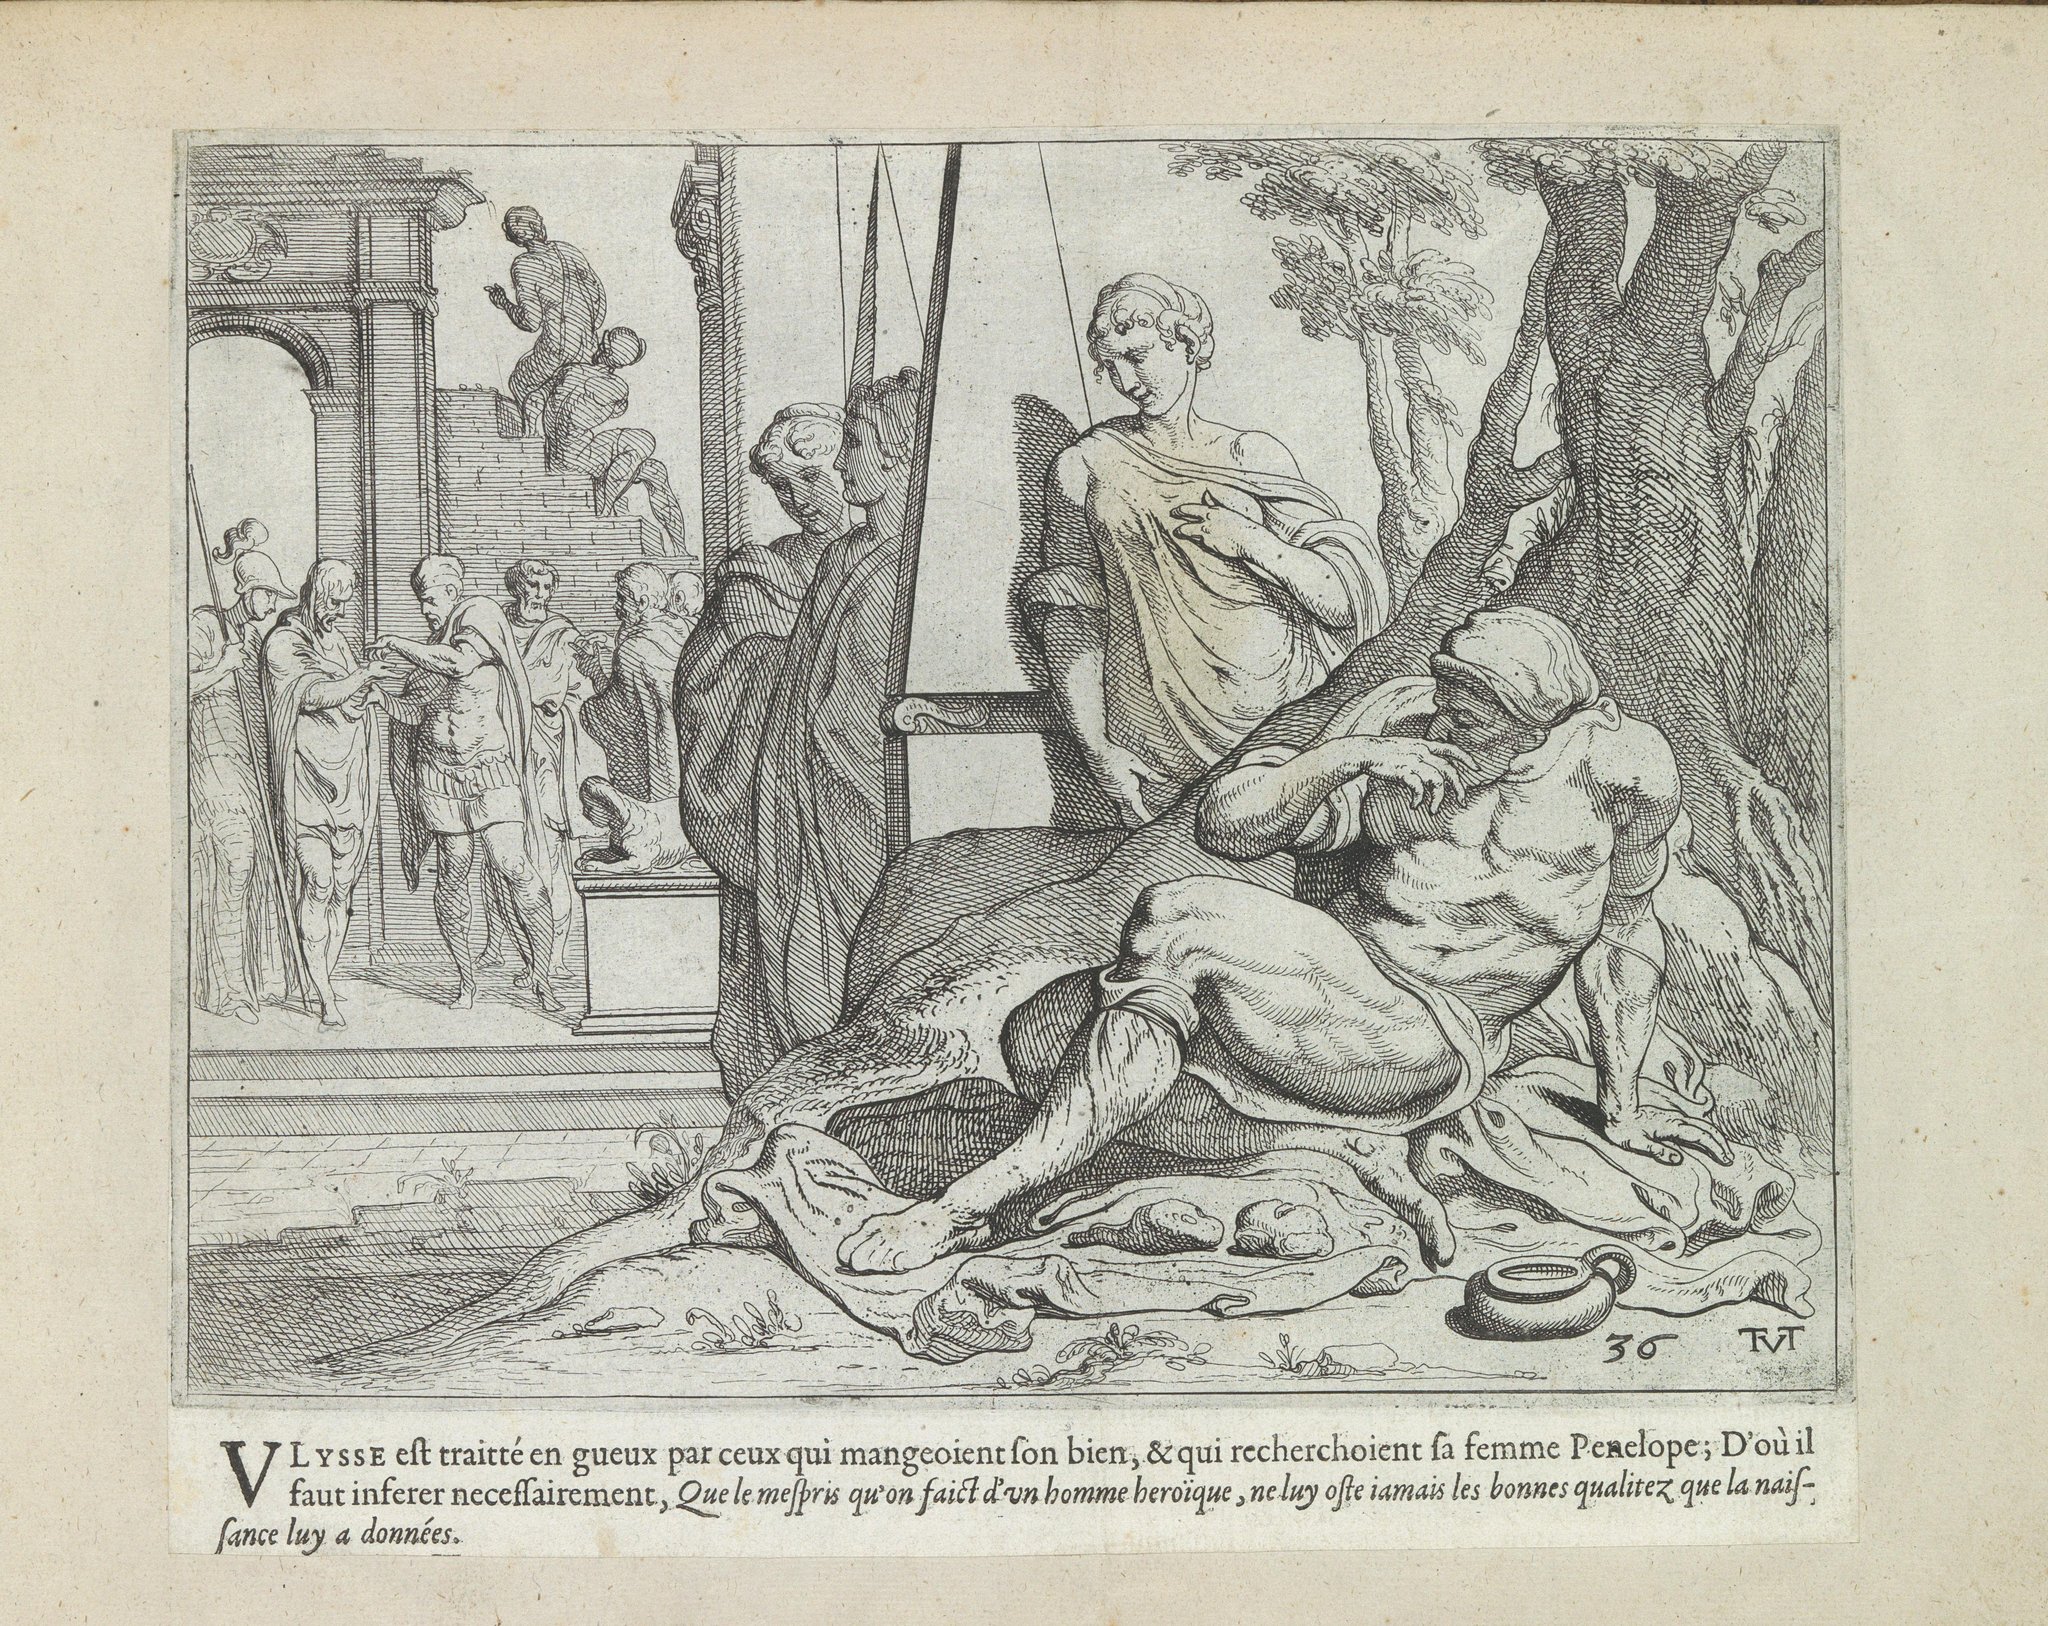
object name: print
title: Les Travaux d'Ulysse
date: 1633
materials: paper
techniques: engraving, etching, letterpress printing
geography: paris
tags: ulysses, still in beggar's guise, arrives in the palace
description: Odysseus zit als bedelaar onder een boom voor zijn paleis op Ithaca. De prent maakt deel uit van een album.